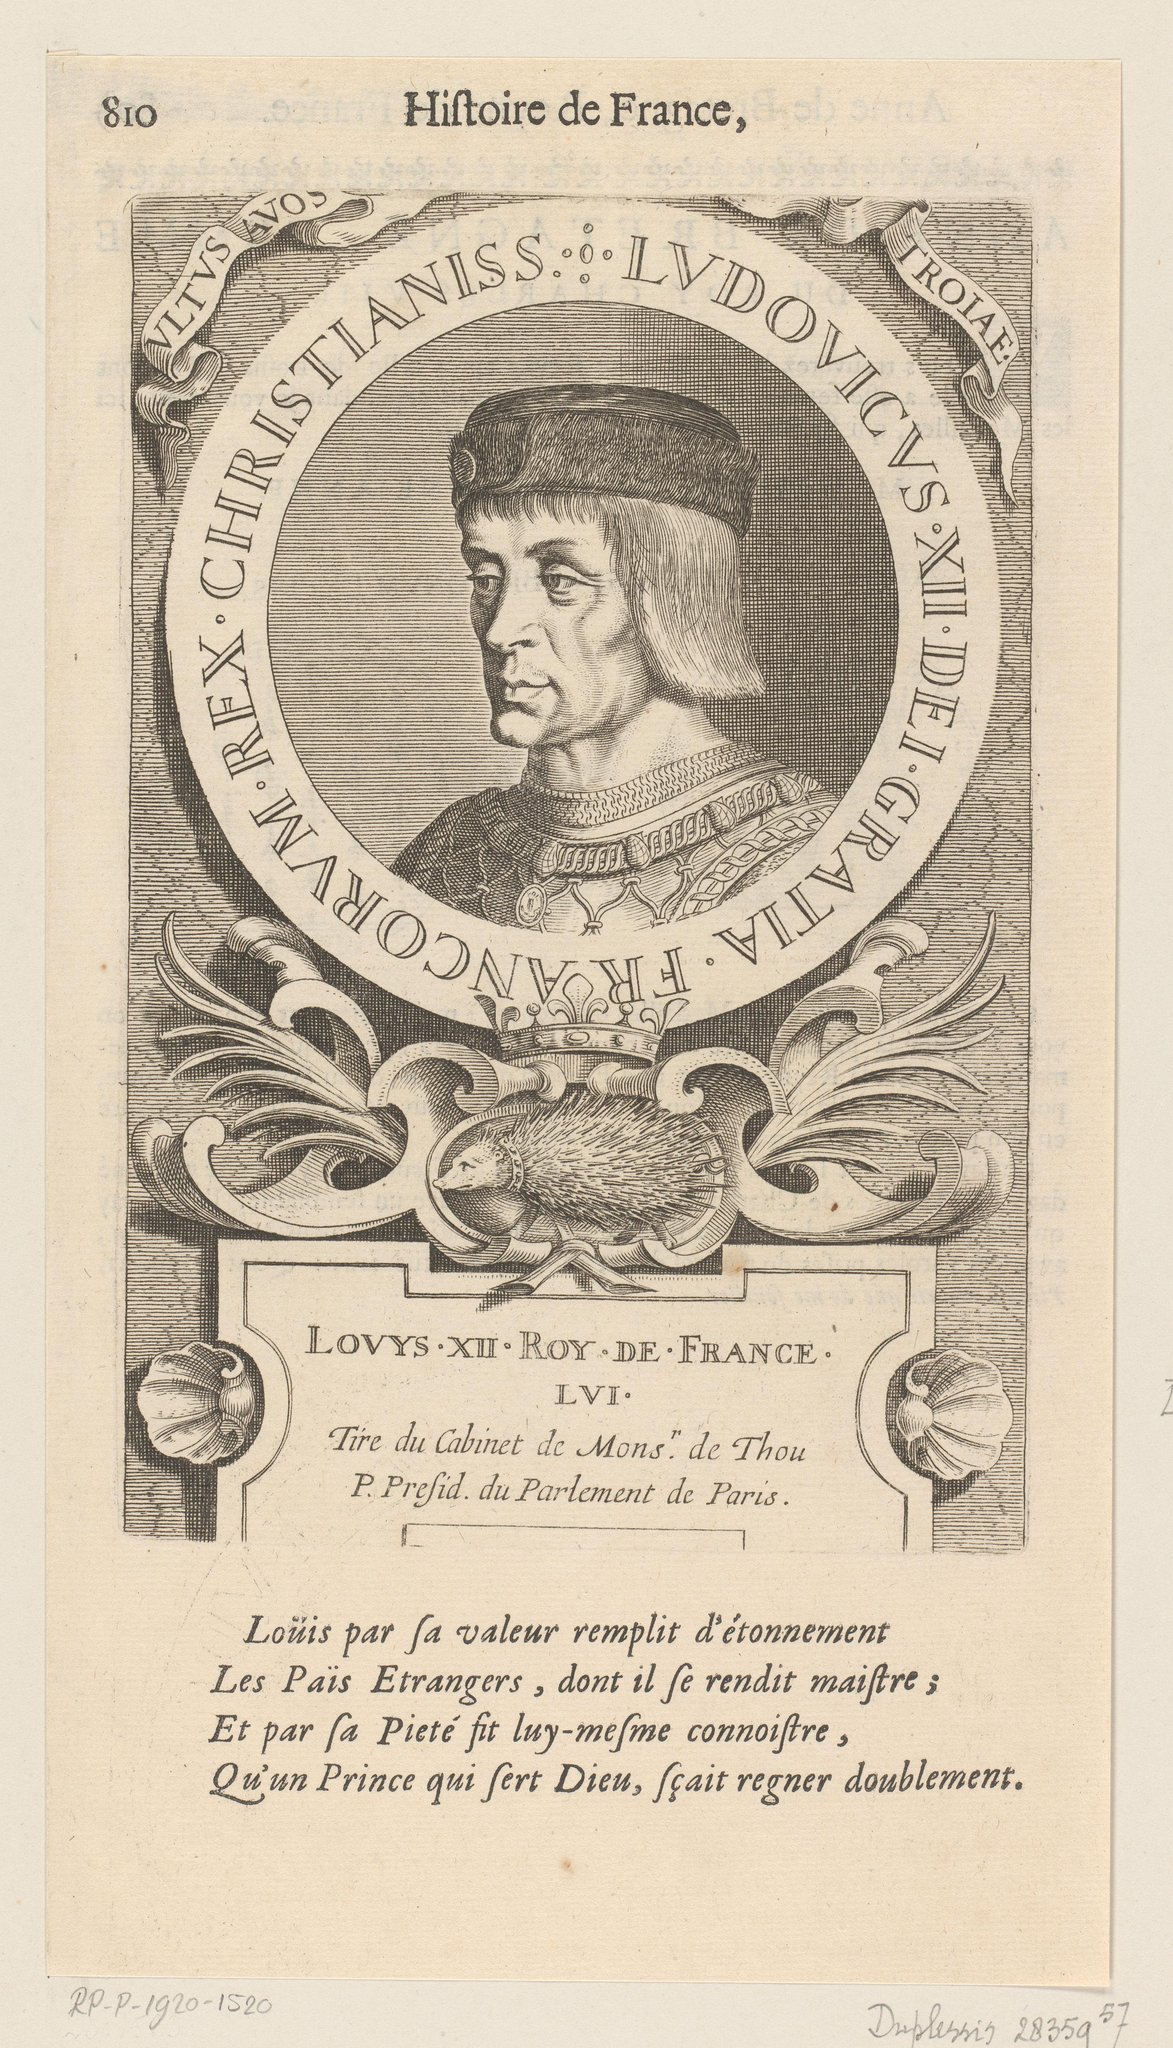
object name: print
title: Portret van Lodewijk XII, koning van Frankrijk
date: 1635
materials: paper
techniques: engraving, letterpress printing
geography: paris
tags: historical persons, ruler, sovereign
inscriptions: collector's mark: Lugt 2228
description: Prent uit: Eudes de Mézeray, François. Histoire de France, depuis Faramond jusqu’au regne de Louis le Juste (...). 3 dln. Parijs: Denis Thierry, Jean Guignard en Claude Barbin, 1635, dl. 2. Prent waarschijnlijk voor het eerst verschenen in: Bie, Jacques de. Les vrais portraits des rois de France (...). Parijs: Jacques de Bie en Pierre Rocolet, 1634. Prent ook gebruikt in latere publicaties.